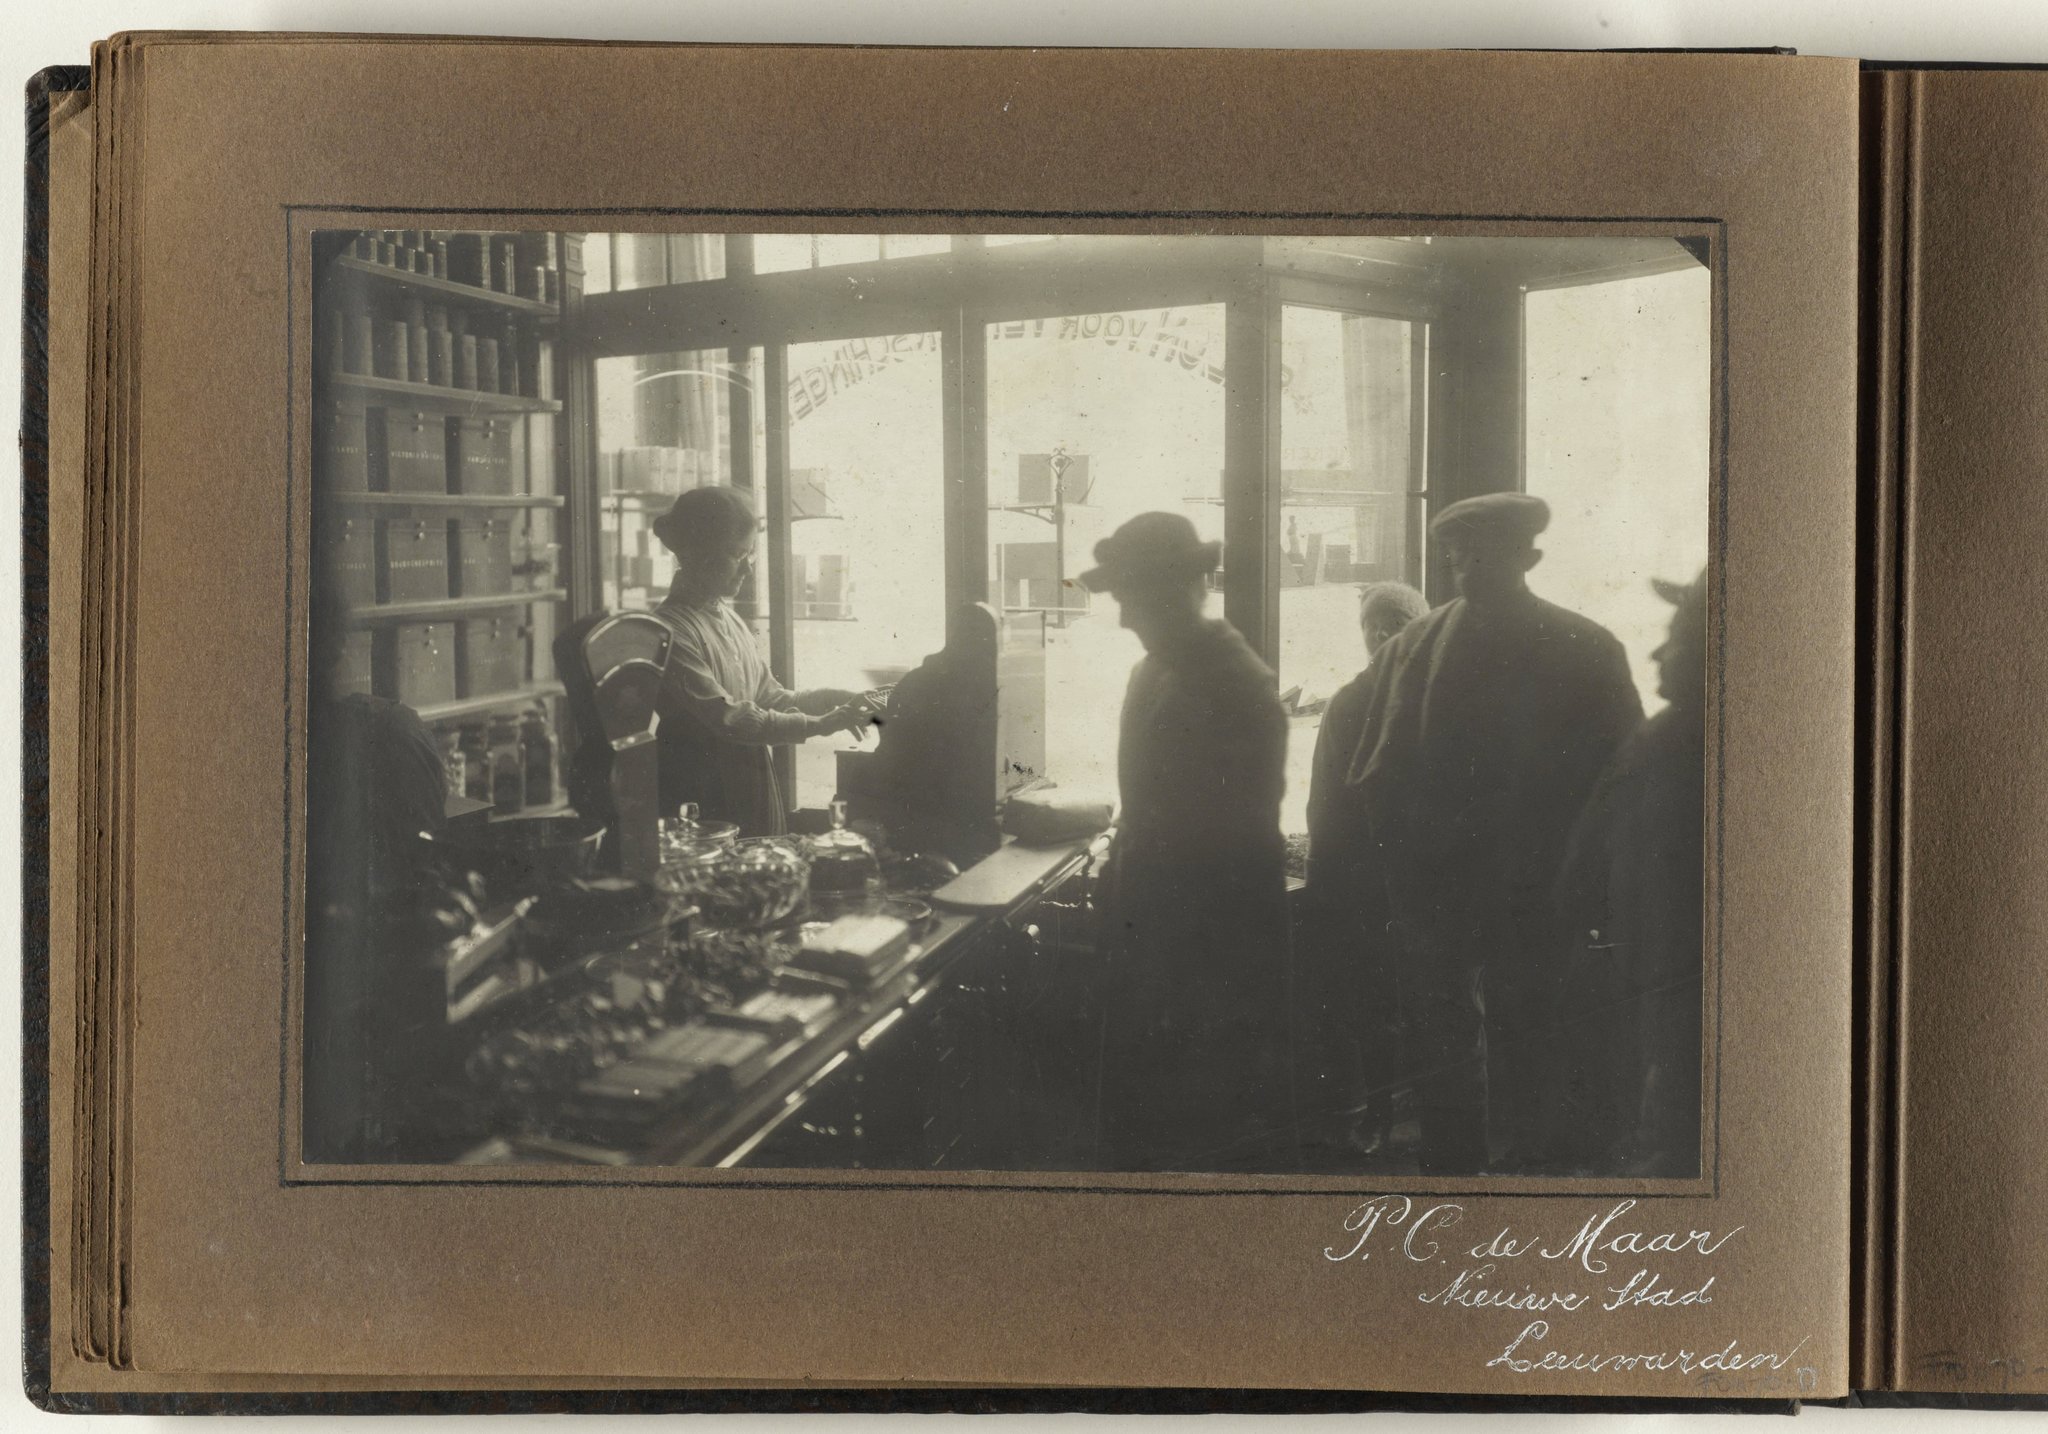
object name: album leaf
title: Interieur van banketbakkerij van P.C. de Maar, Nieuwe Stad, Leeuwarden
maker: Anonymous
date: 1925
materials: paper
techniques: gelatin silver print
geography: leeuwarden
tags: confectioner, counter ~ shop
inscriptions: annotation: ‘P.C. de Maar/ Nieuwe Stad/ Leeuwarden’